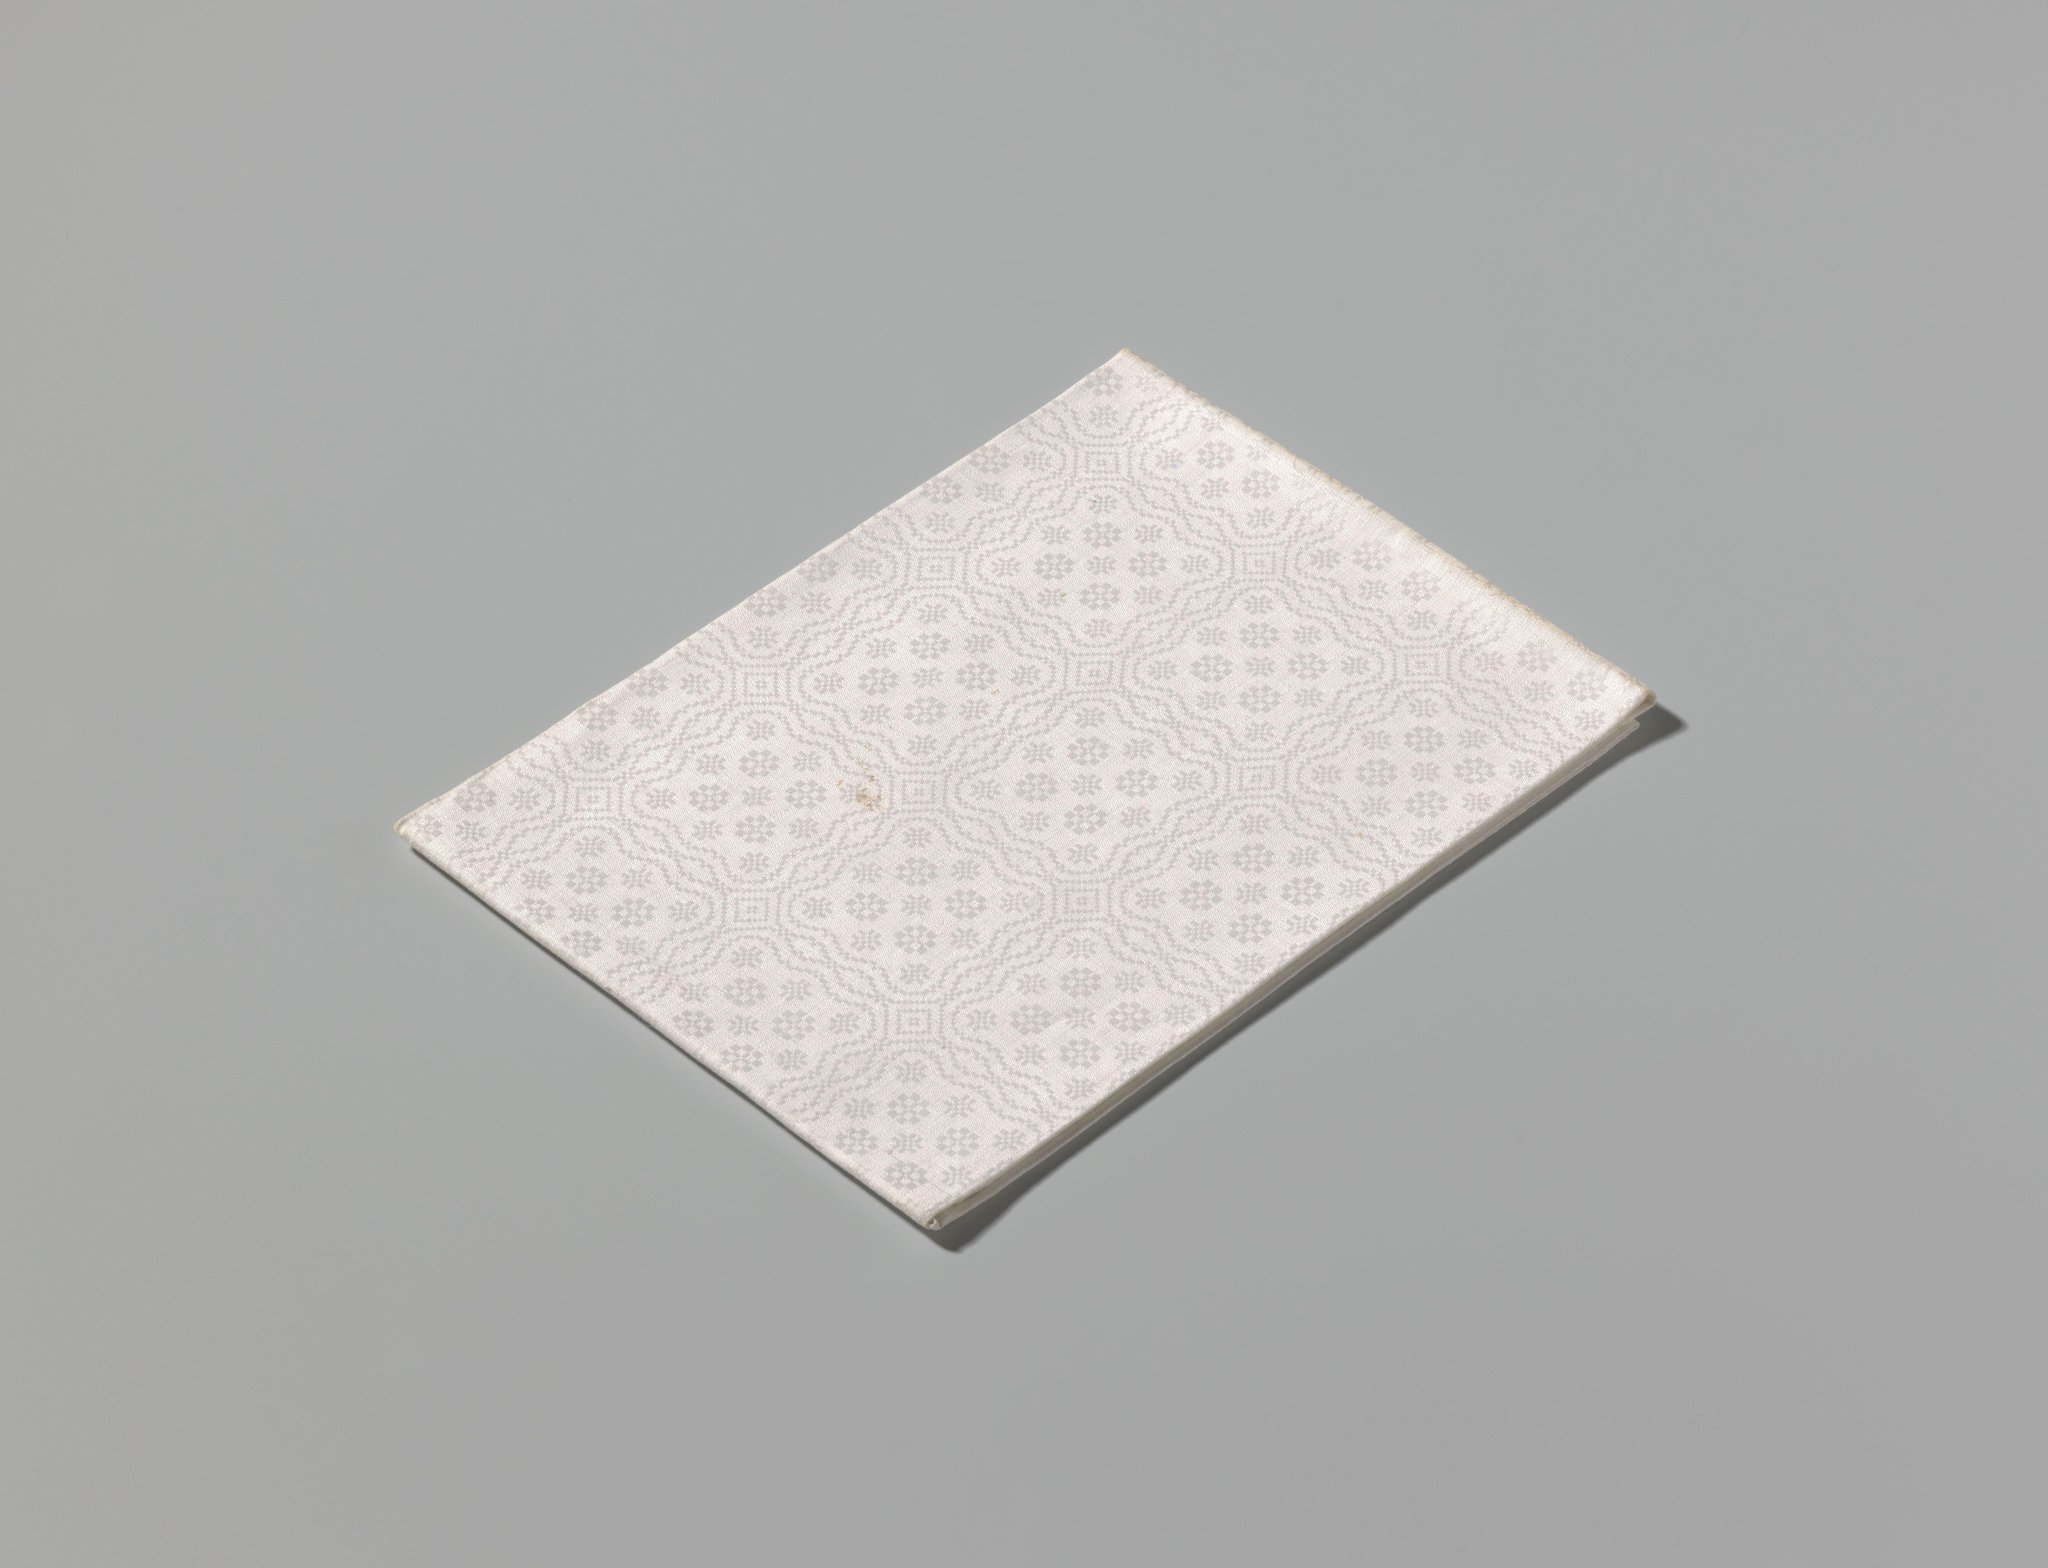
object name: napkin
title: Servet van linnen met pellenpatroon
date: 1692-1735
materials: linen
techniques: peeled fabric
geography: northern netherlands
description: wit linnen servet met pellen patroon, merk GS 36